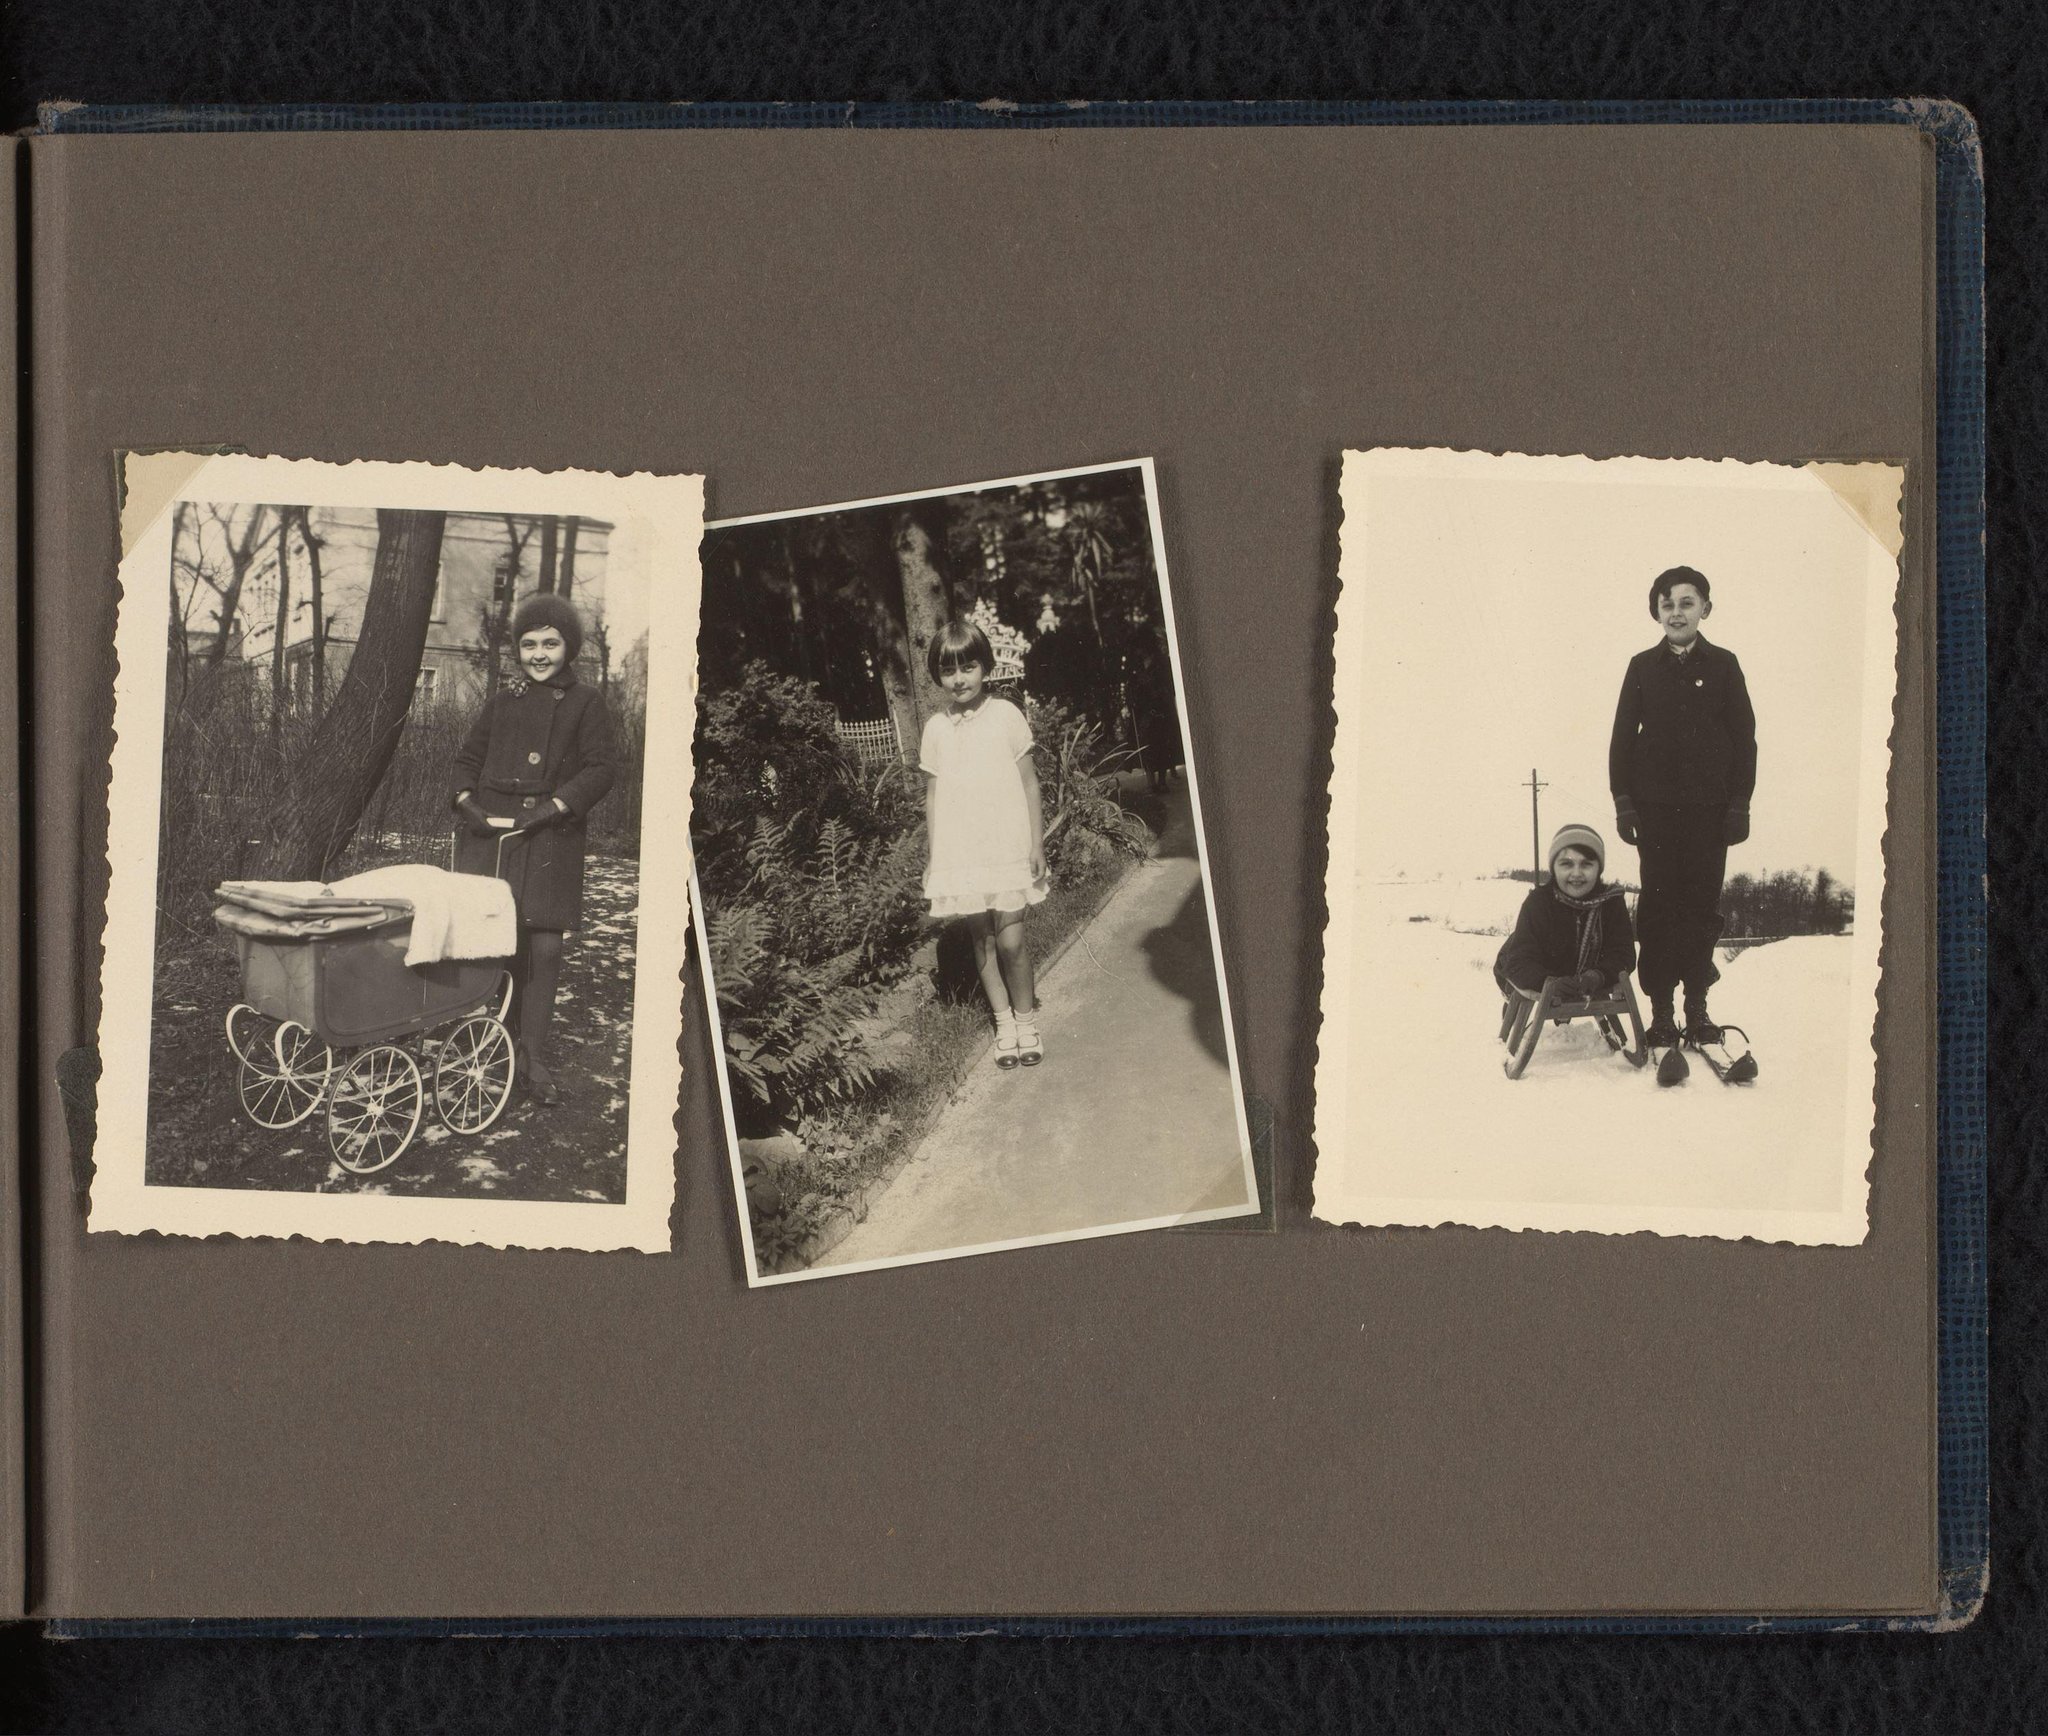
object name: photograph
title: Kinderen van de familie Naumann, vermoedelijk na juli 1932, vermoedelijk in Albeck (Oostenrijk)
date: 1907-1932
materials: paper, photographic support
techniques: gelatin silver print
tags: austria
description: Albumblad bevat drie foto's (één los) van kinderen van de familie Naumann. Uit album half formaat, blauw kunstlederen omslag met koordbinding.